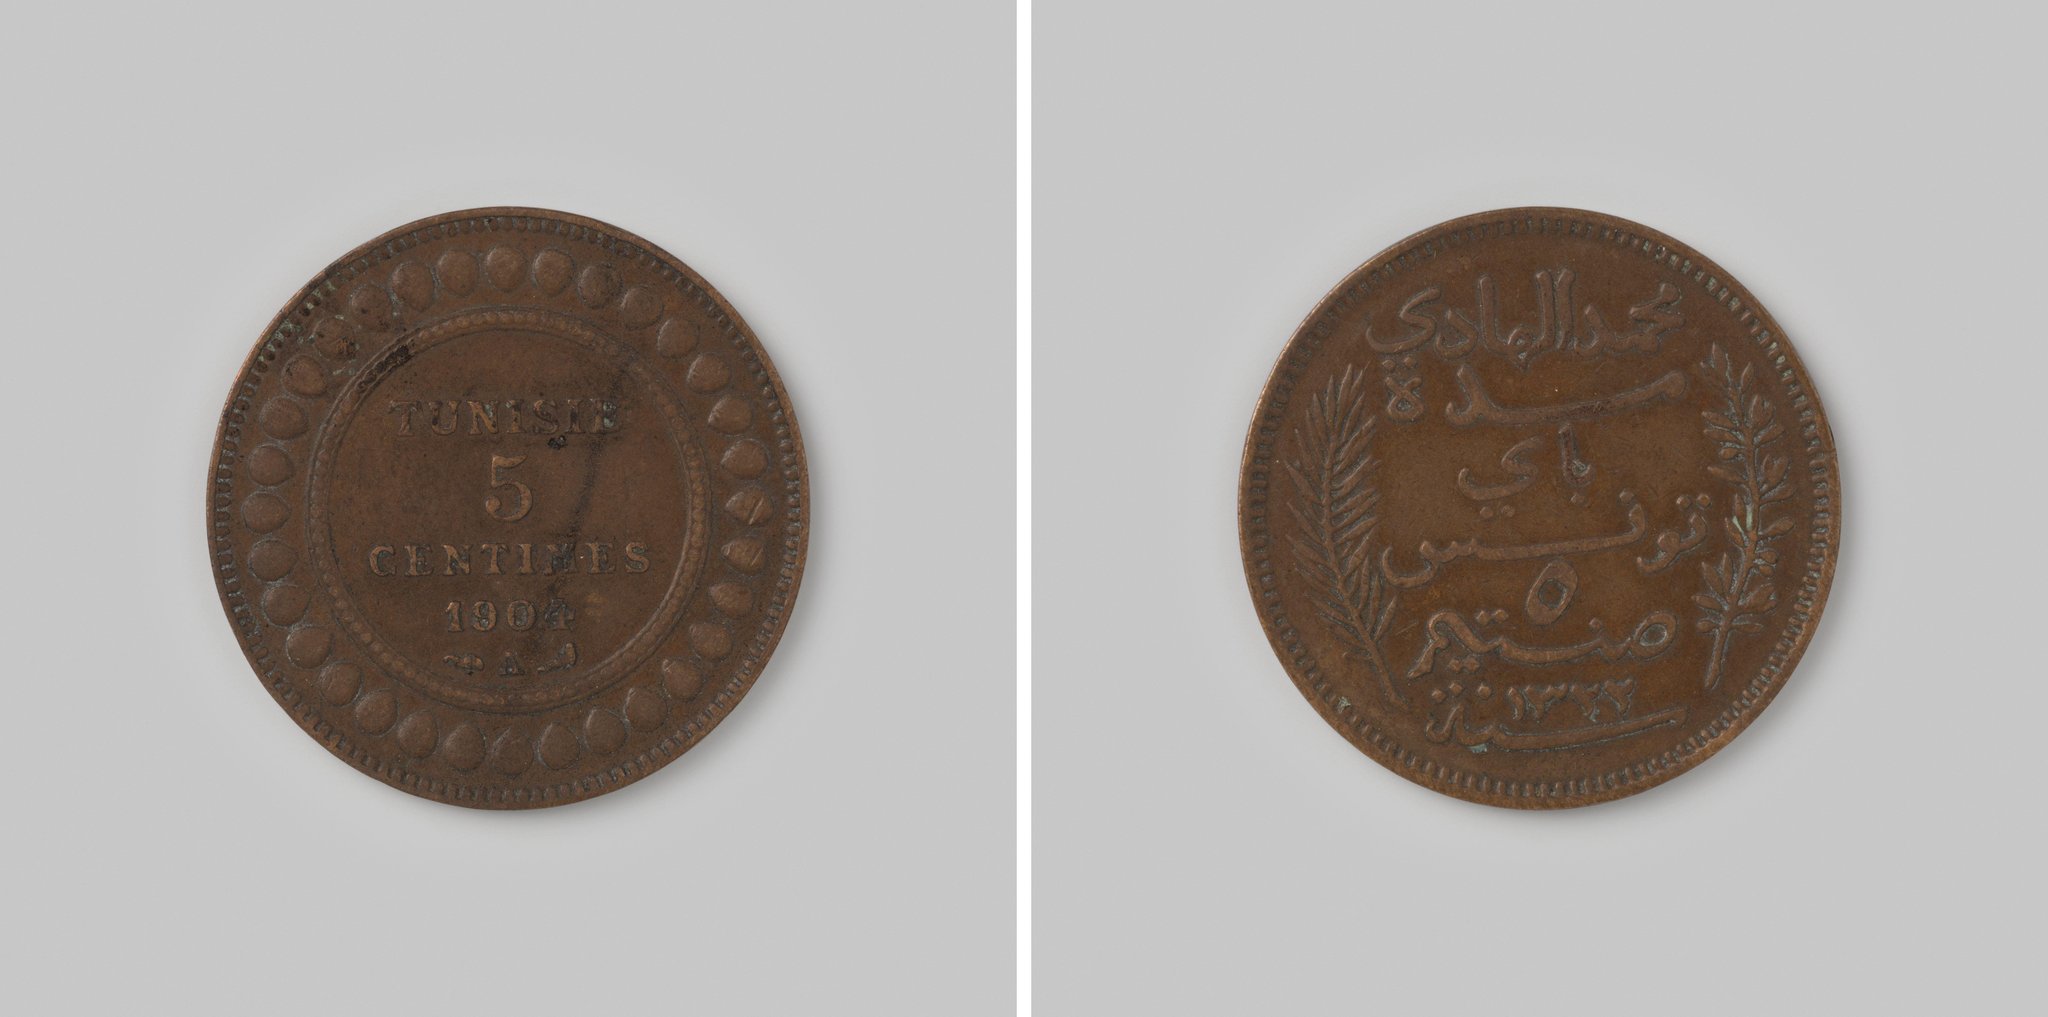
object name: vijf centime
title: 5 centimes uit Tunesië als Frans protectoraat onder de bey Mohammed al-Hadi, 1904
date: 1904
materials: bronze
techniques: striking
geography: paris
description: Bronzen munt. Voorzijde: binnen een ring van druppelvormige figuren cirkel. Daarin waarde-aanduiding in twee regels, waarboven lands-aanduiding en waaronder jaartal: 1904. Onder jaartal letter A [=Parijs]. Keerzijde: tussen twee takken vierregelig opschrift in Arabische letters met naam van de bey, lands-aanduiding: Tunisiya en waarde-aanduiding. Daaronder jaartal: 1322 [=1904]. Gladde rand.